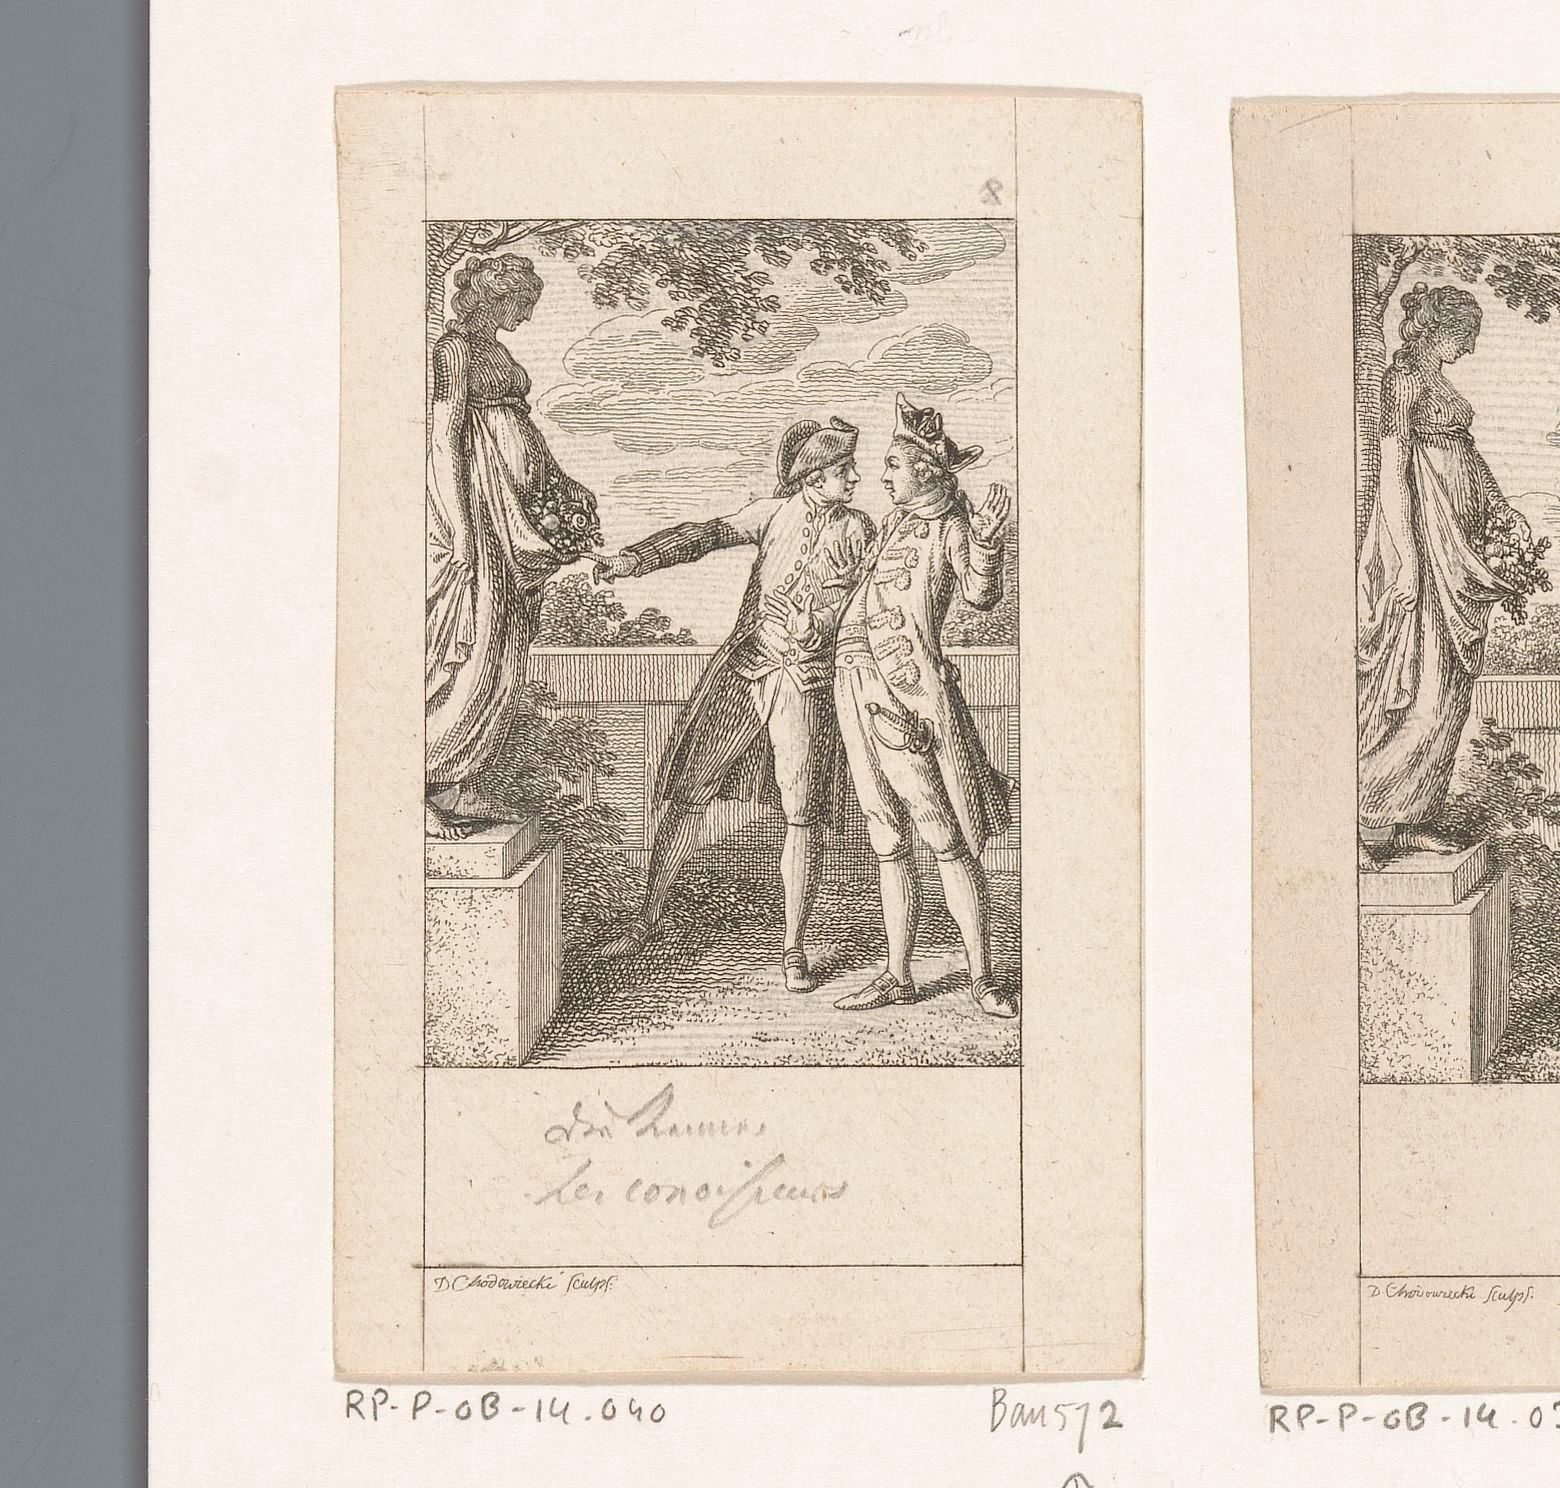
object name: print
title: Twee kunstkenners bekijken een sculptuur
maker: daniel nikolaus chodowiecki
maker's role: draughtsman, print maker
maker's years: 1726-1801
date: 1779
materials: paper, pencil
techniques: etching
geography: berlin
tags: physicist, criticizing and discussing art, art criticism, statues, sculptures in garden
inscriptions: collector's mark: Lugt 2228, inscription: ‘die Kenner / les conoisseurs’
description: Achtste prent uit een serie van twaalf taferelen die 'Natürliche und affectirte Handlungen des Lebens' (tweede serie) illustreren waarin 'natuurlijk' en 'geaffecteerd' gedrag op karikaturale wijze tegenover elkaar worden gezet. Deze taferelen zijn op een plaat geëtst. Een latere staat van deze serie, voorzien van toelichtingen door Georg Christoph Lichtenberg, is ook gebruikt in: Almanac de Goettingue pour l'année 1780. Göttingen: Johann Christian Dieterich.